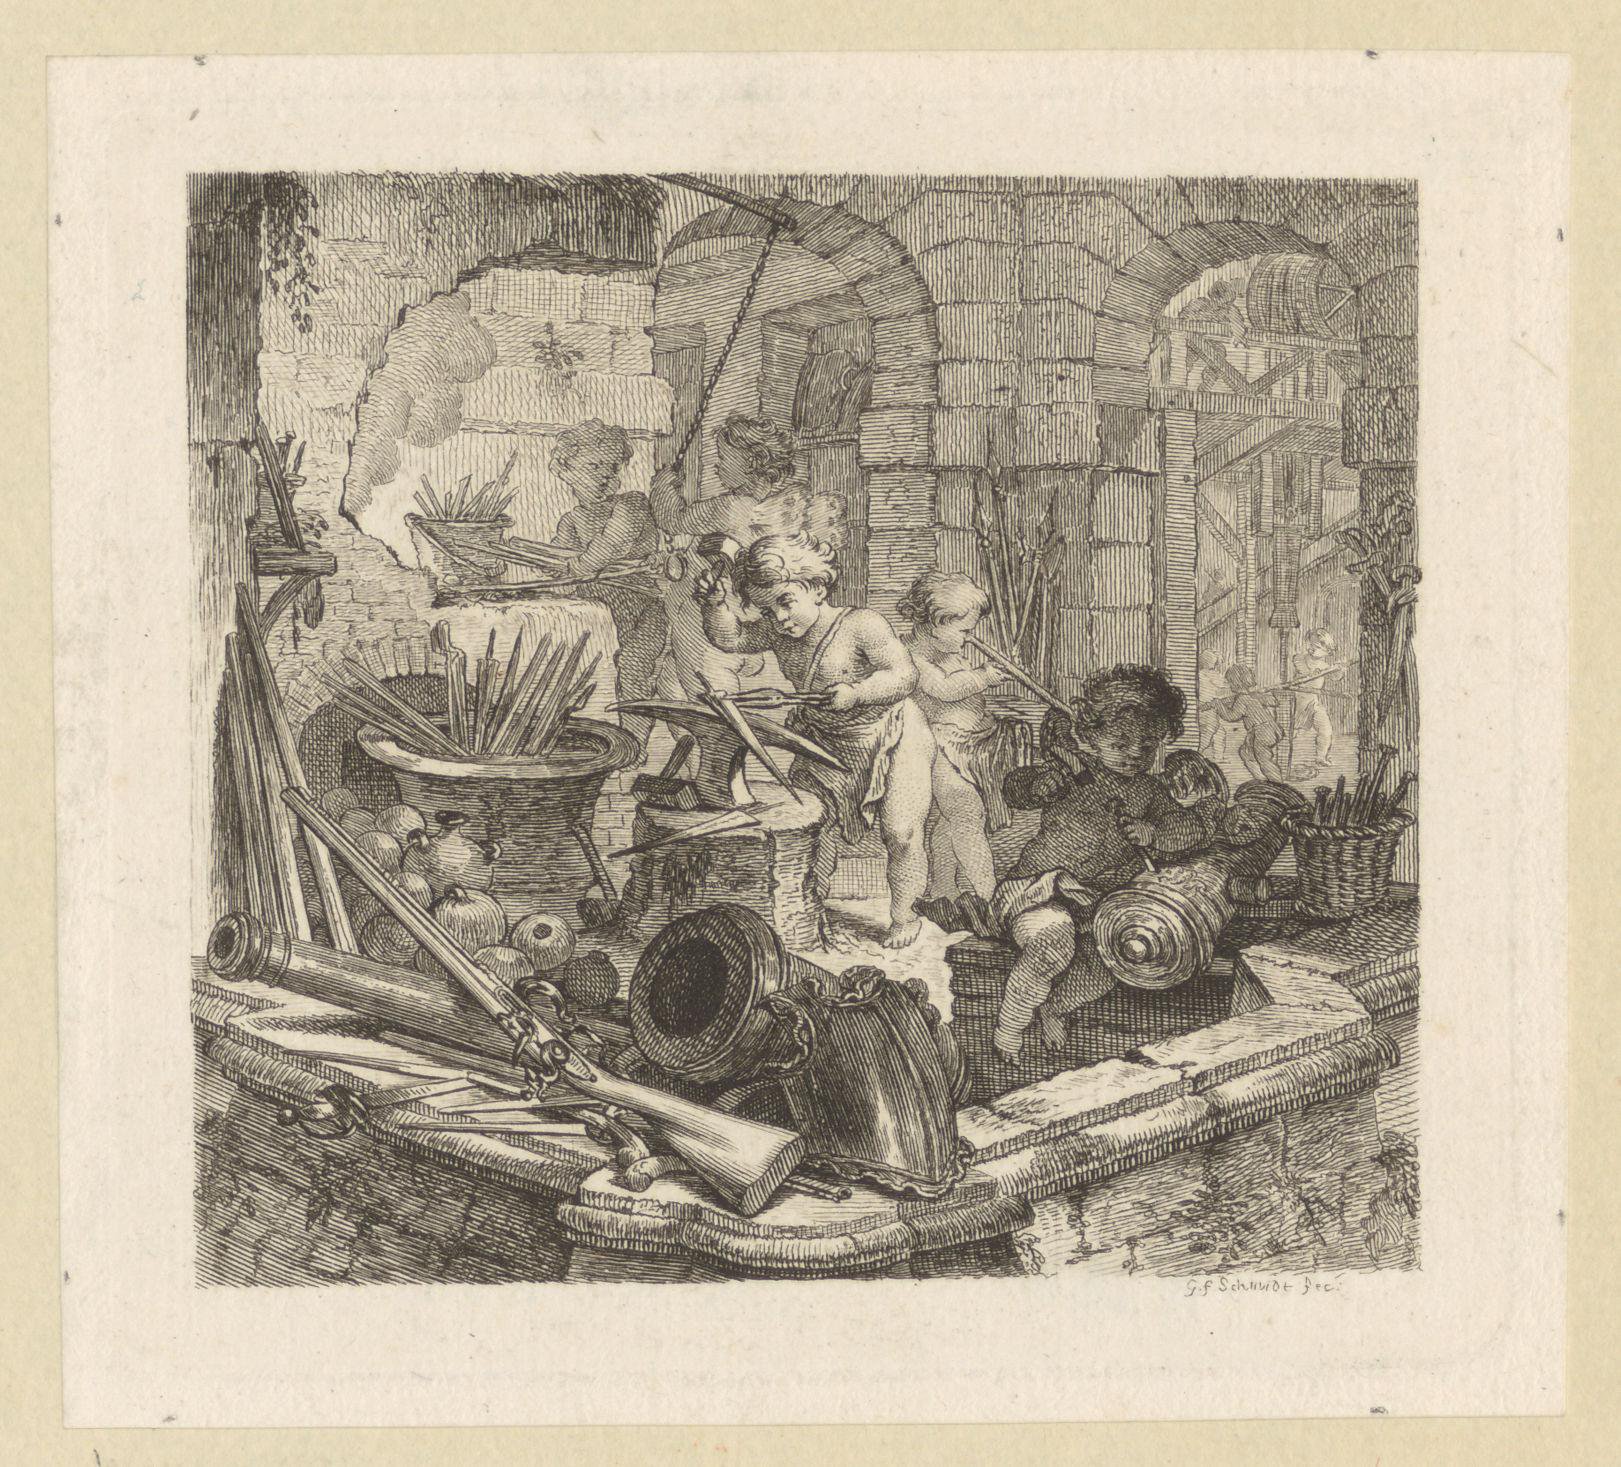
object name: book illustration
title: Putti smeden wapens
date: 1760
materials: paper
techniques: etching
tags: gun-smith, rifle-maker, armourer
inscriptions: collector's mark: Lugt 240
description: Prent ook gebruikt in: Frederik de Grote. Poësies diverses. Sanssouci, Frederik de Grote, 1760.